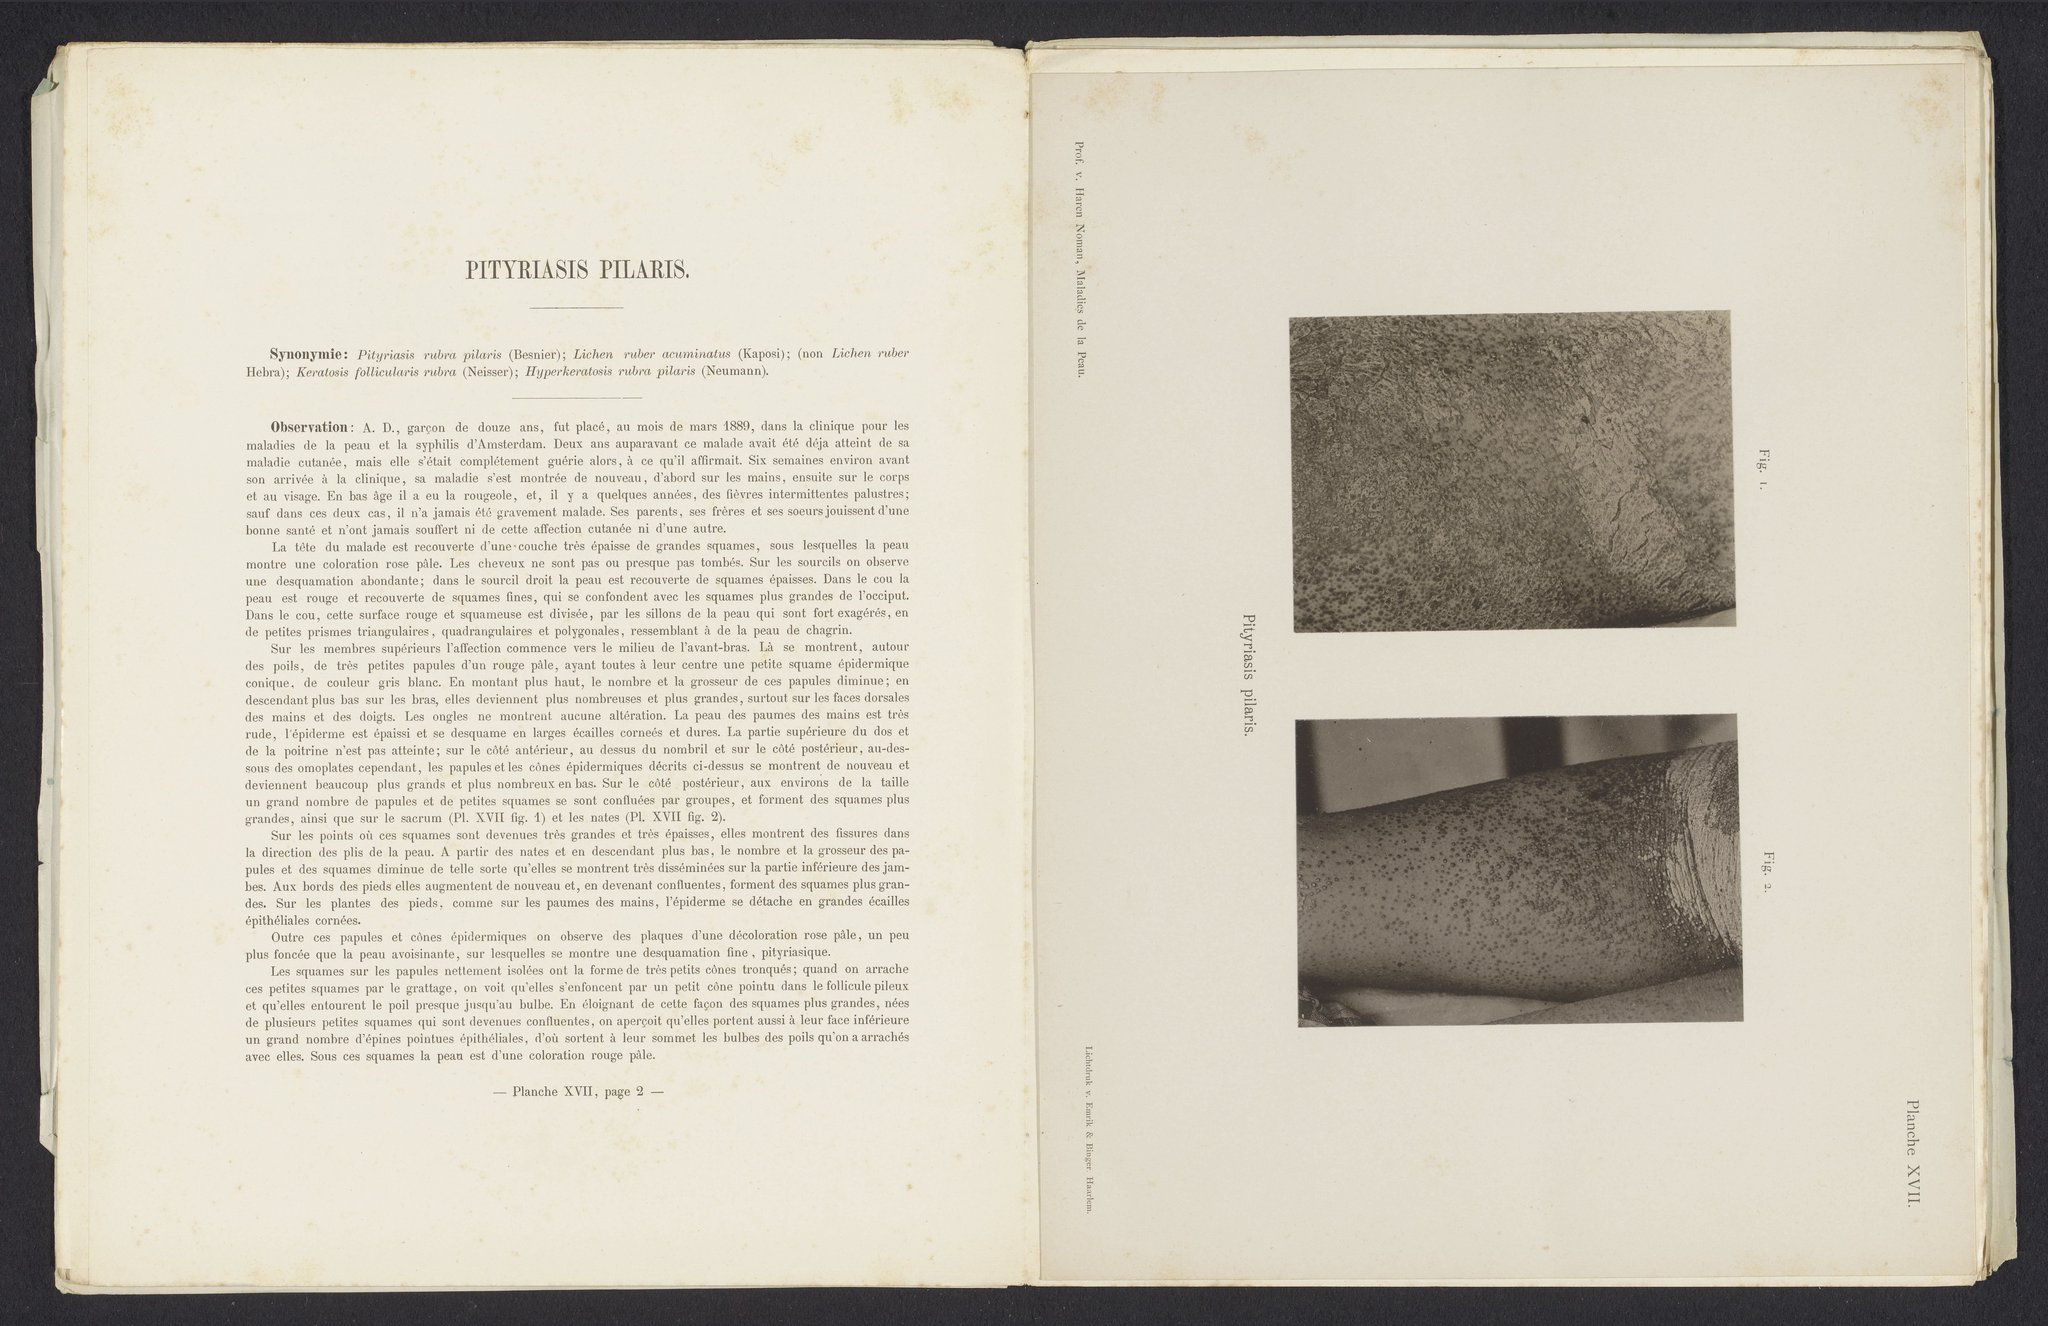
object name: page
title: Pityriasis pilaris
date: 1882-1892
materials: paper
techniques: photograph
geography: haarlem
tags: skin and venereal diseases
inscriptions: number: ‘Planche XVII. / Fig. 1. / Fig. 2.’